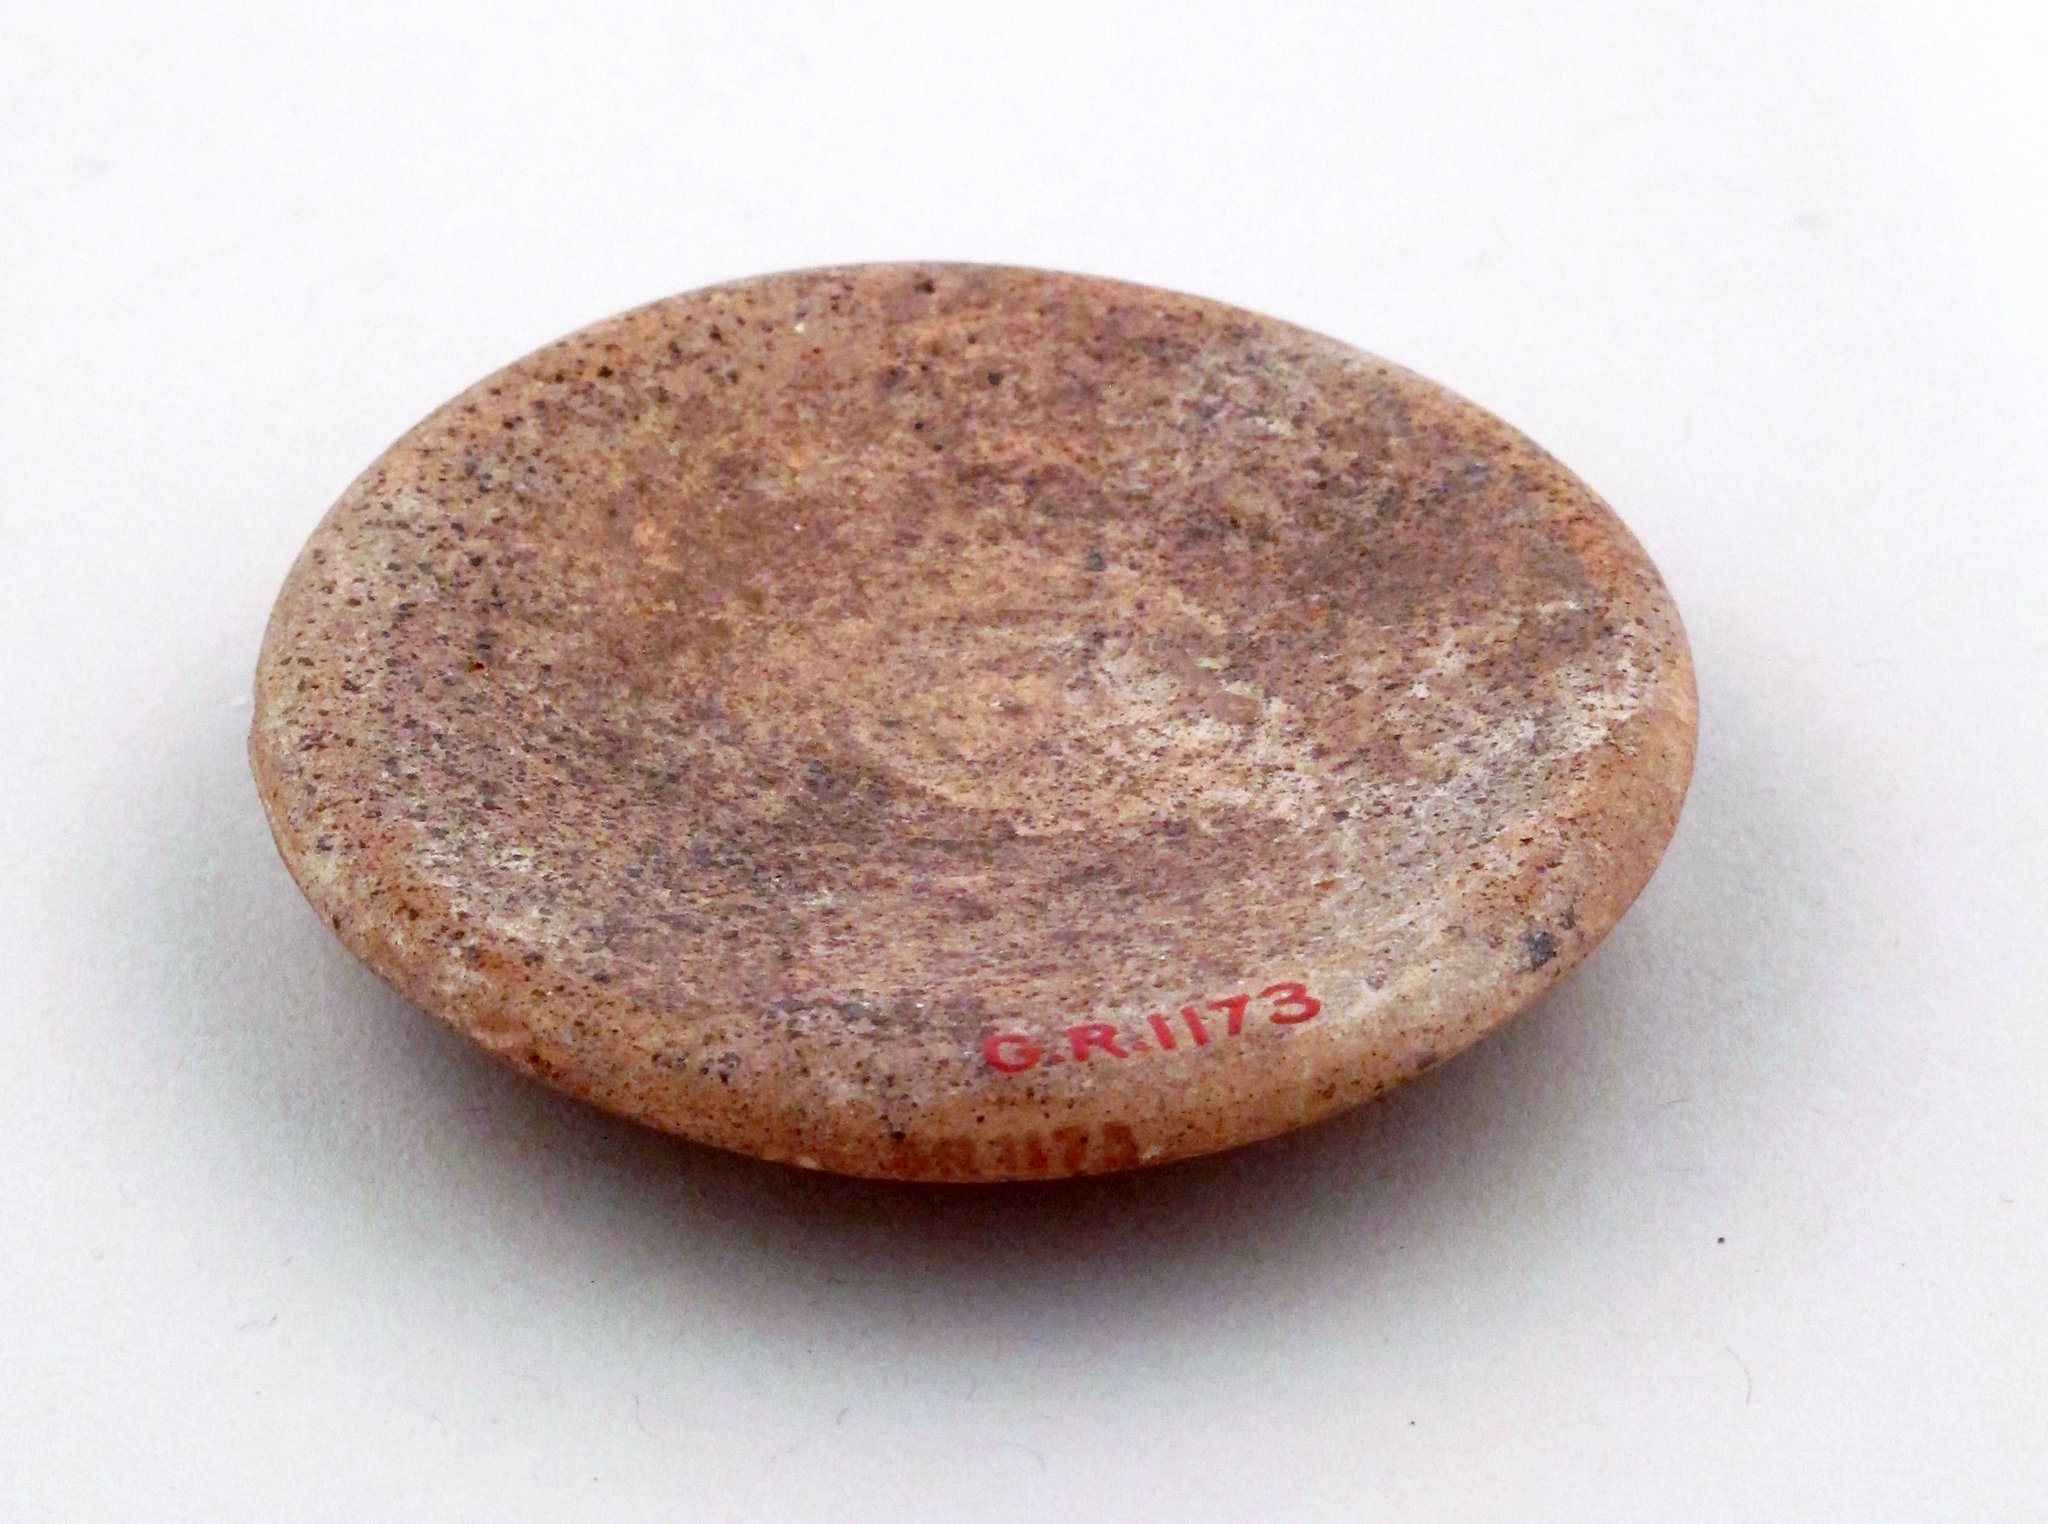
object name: phiale, miniature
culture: etruscan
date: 300-101 BCE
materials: terracotta